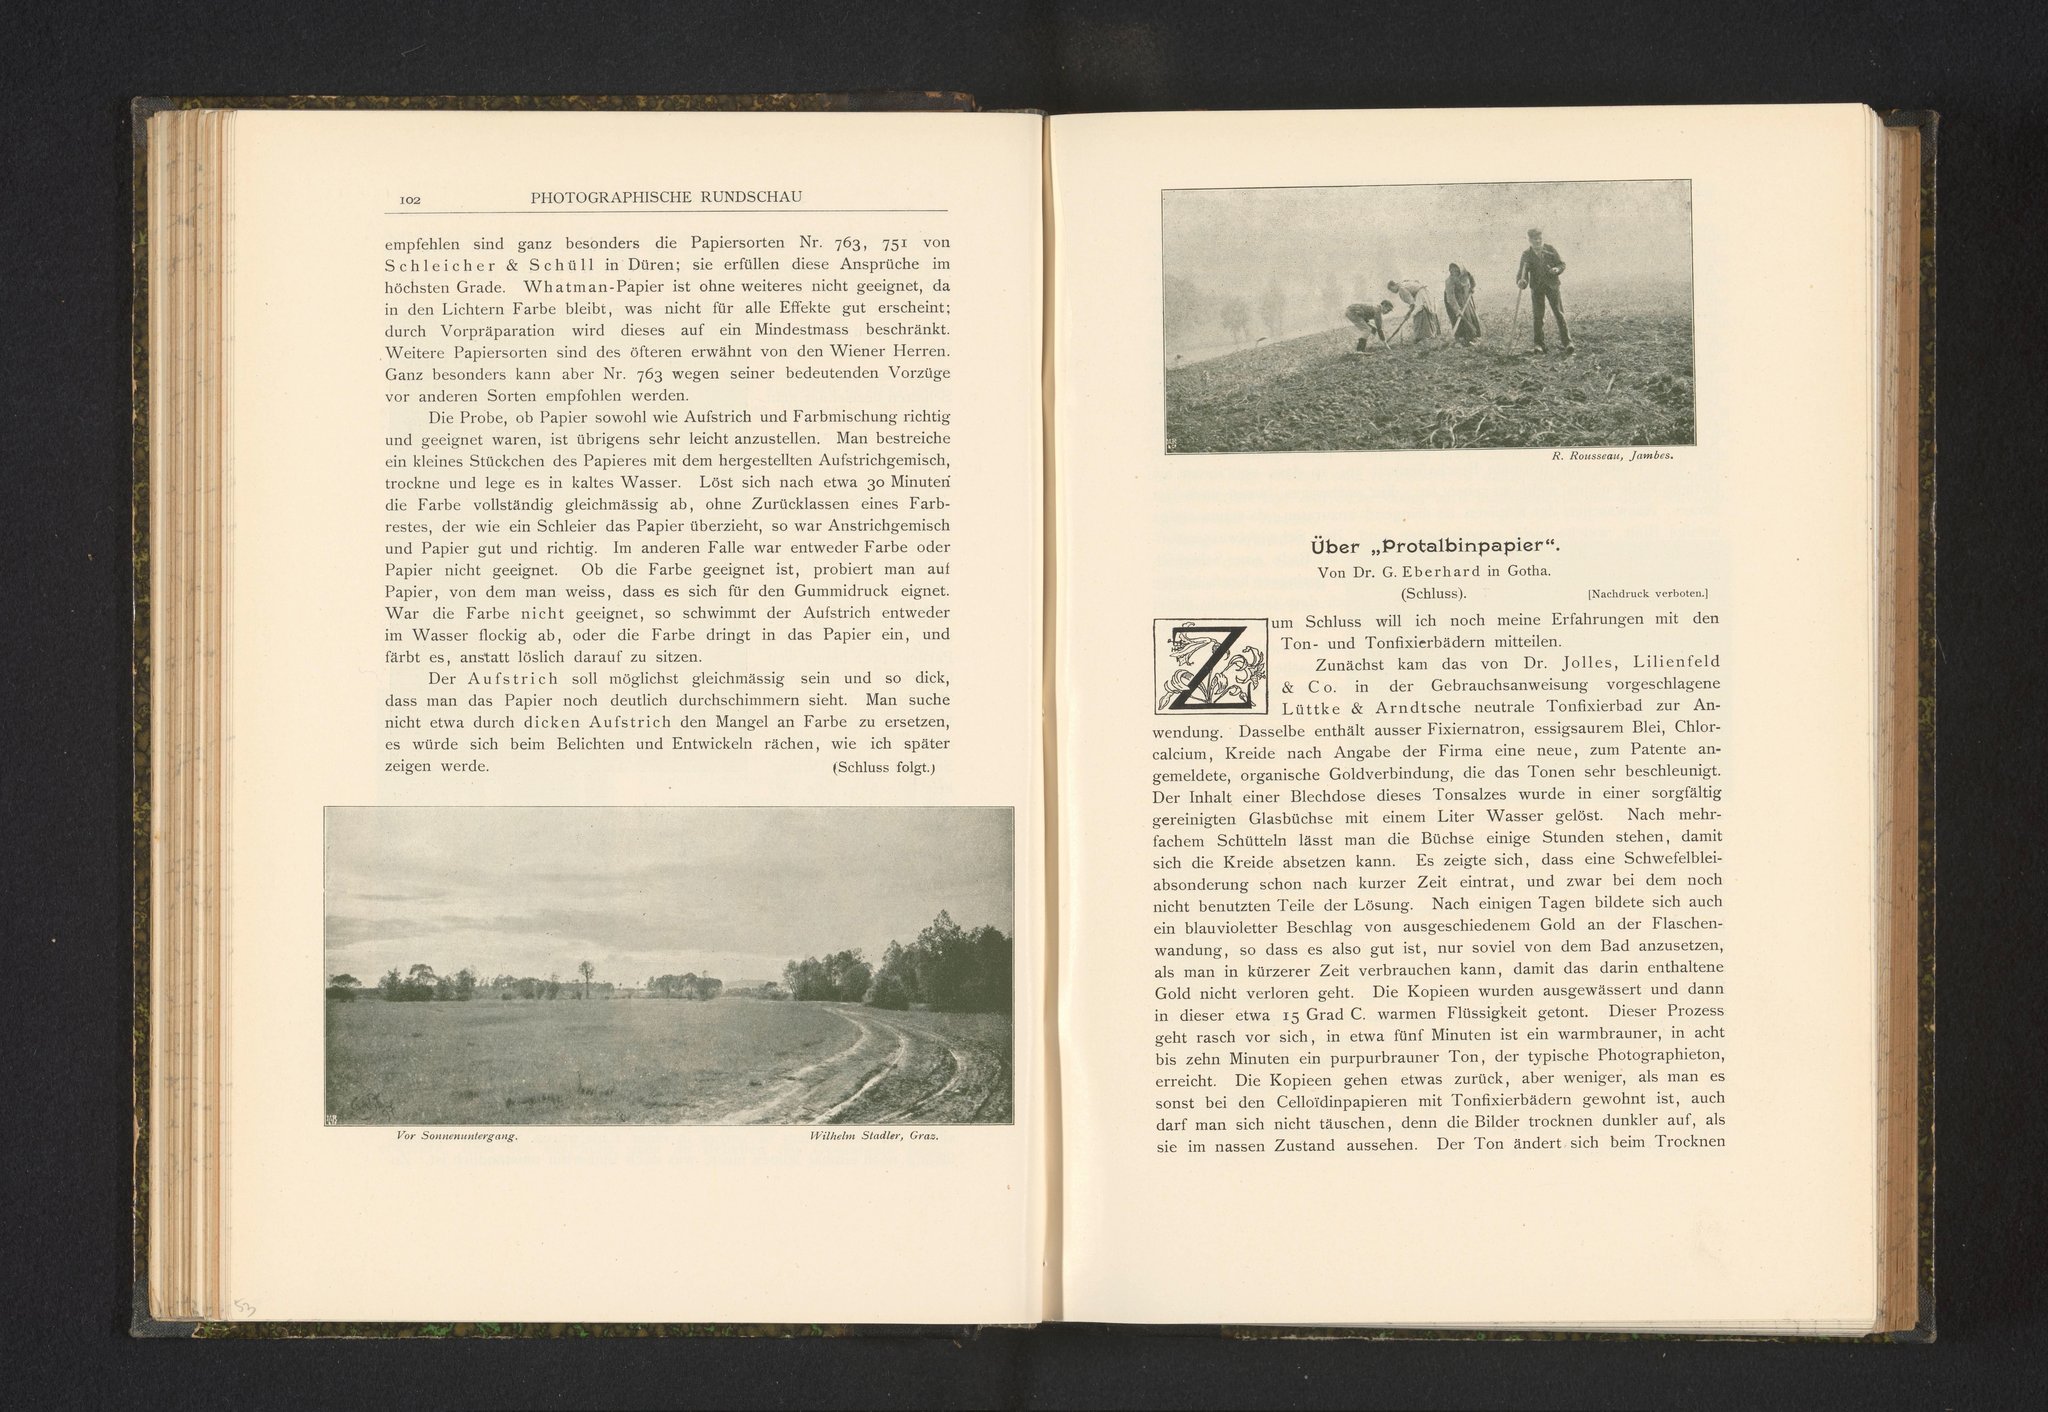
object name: photomechanical print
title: Boeren bewerken het land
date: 1893-1898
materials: paper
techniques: autotype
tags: farmers, cultivation ~ agriculture